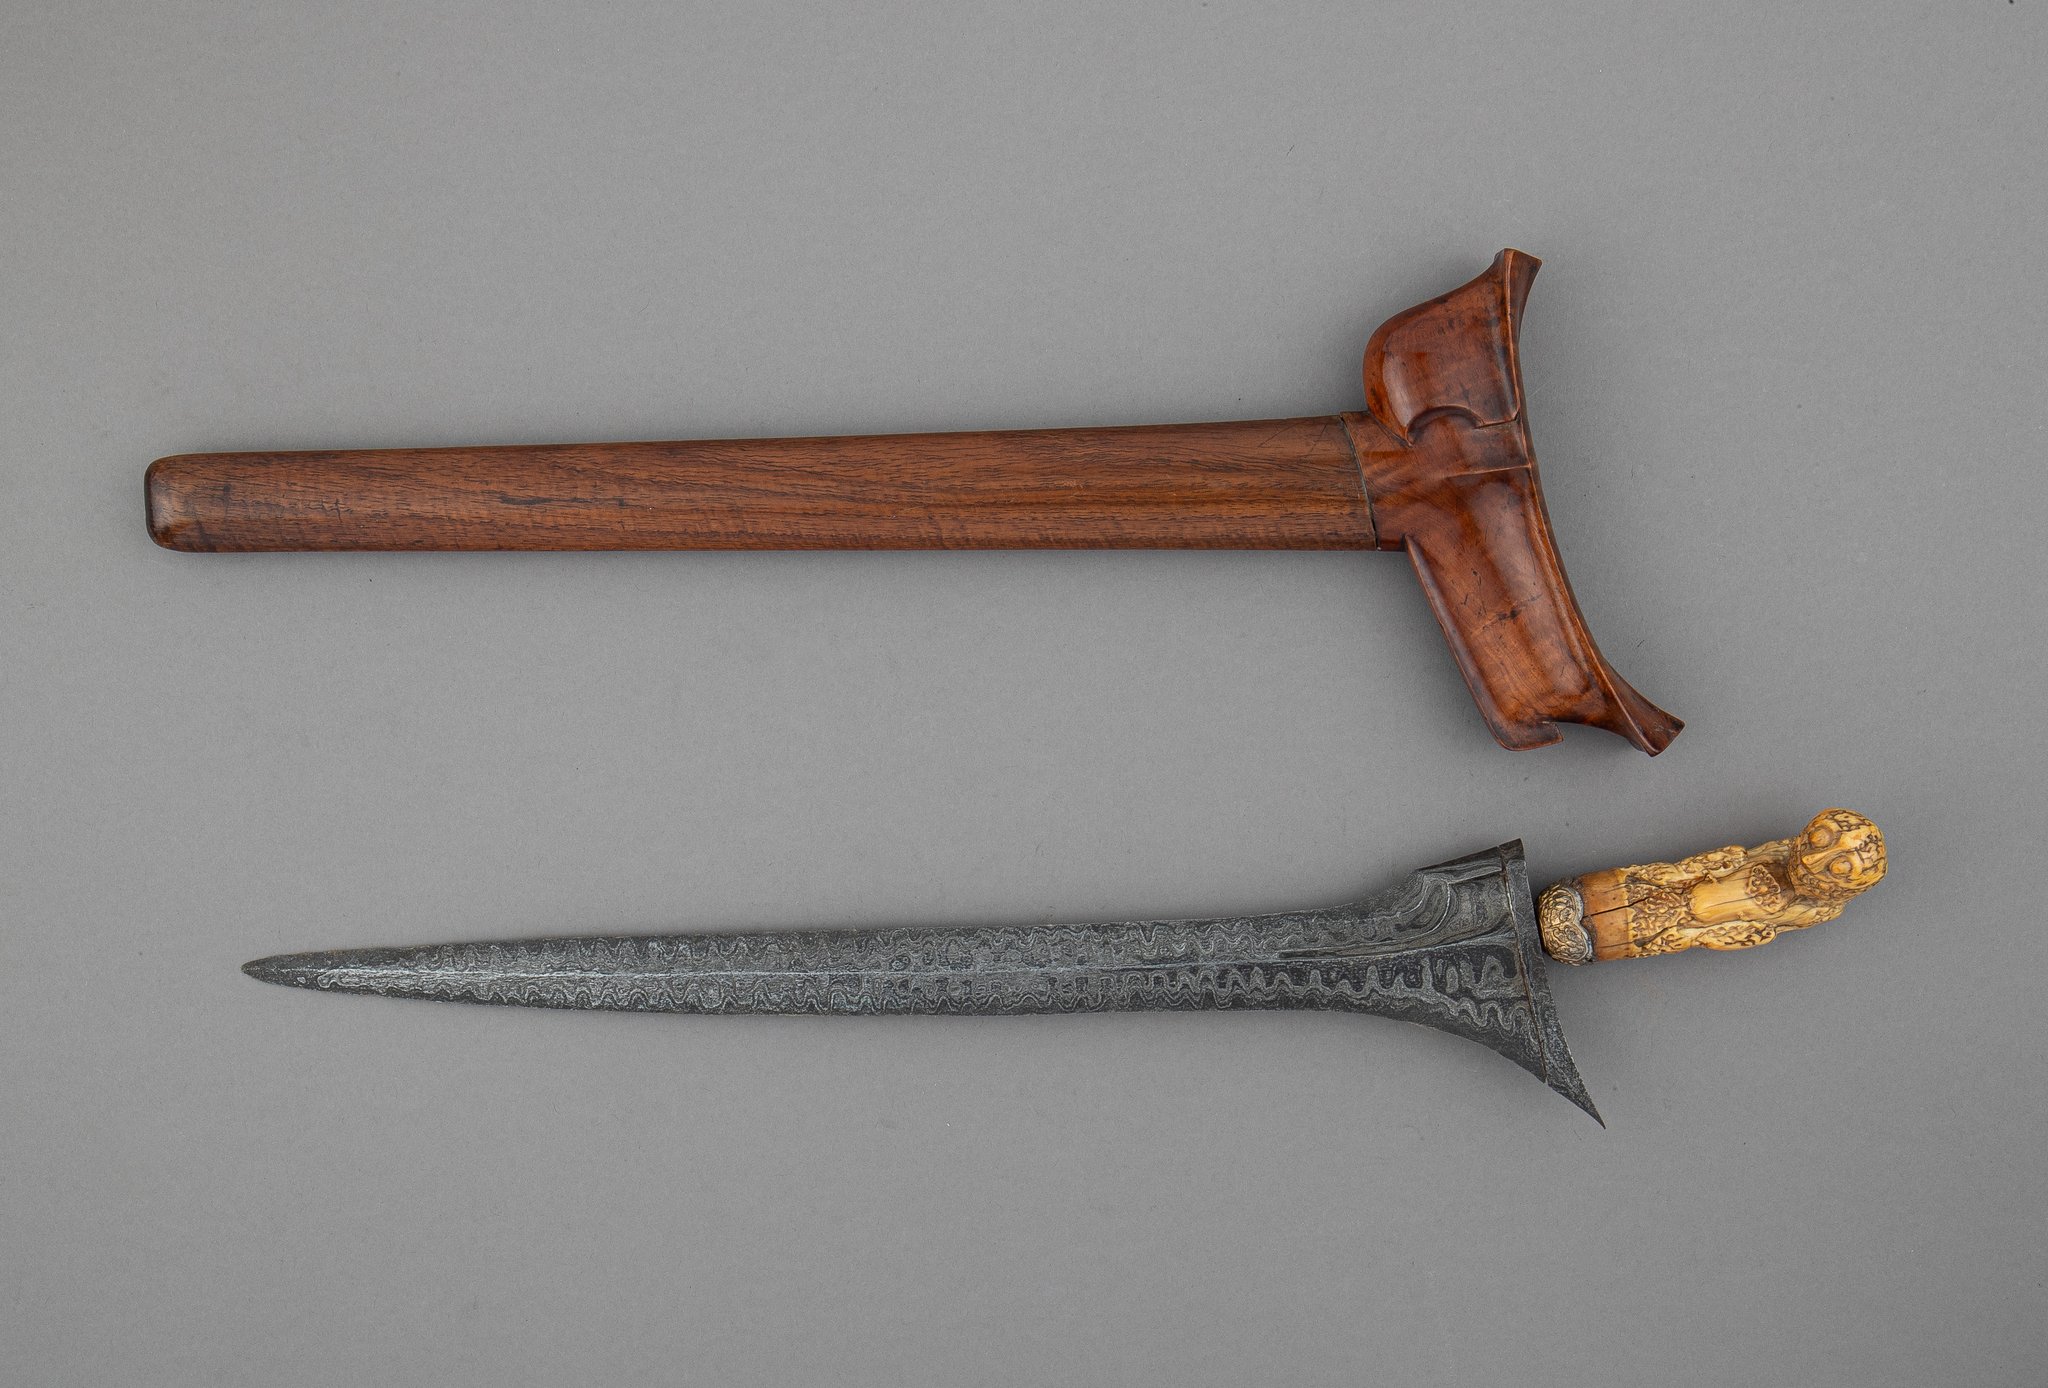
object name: kris with sheath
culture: sumatran or acheen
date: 1701-1800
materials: gold, iron, ivory, silver, wood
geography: indonesia